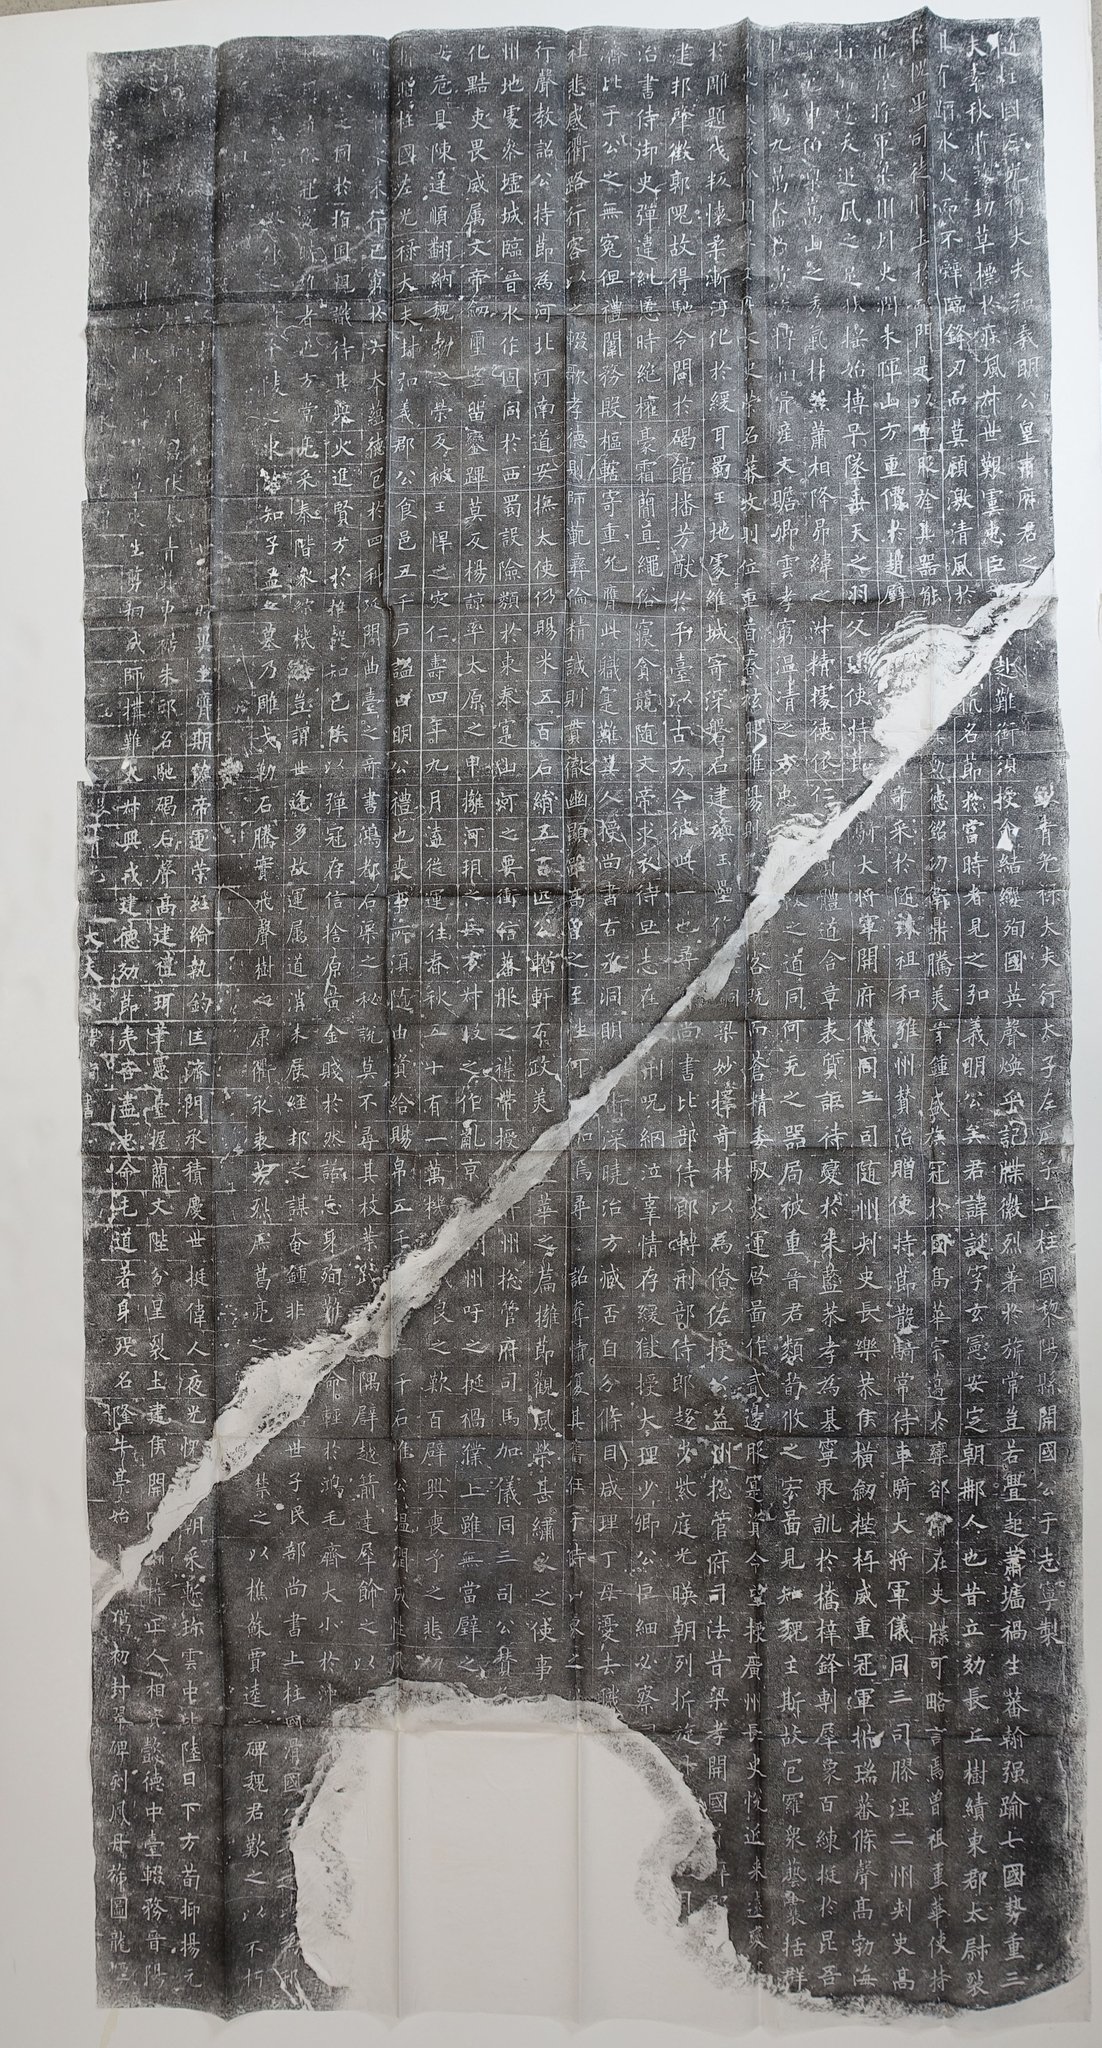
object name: rubbing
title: Epitaph for Huangfu Dan (died 604)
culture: chinese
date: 1901-2000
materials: ink, paper